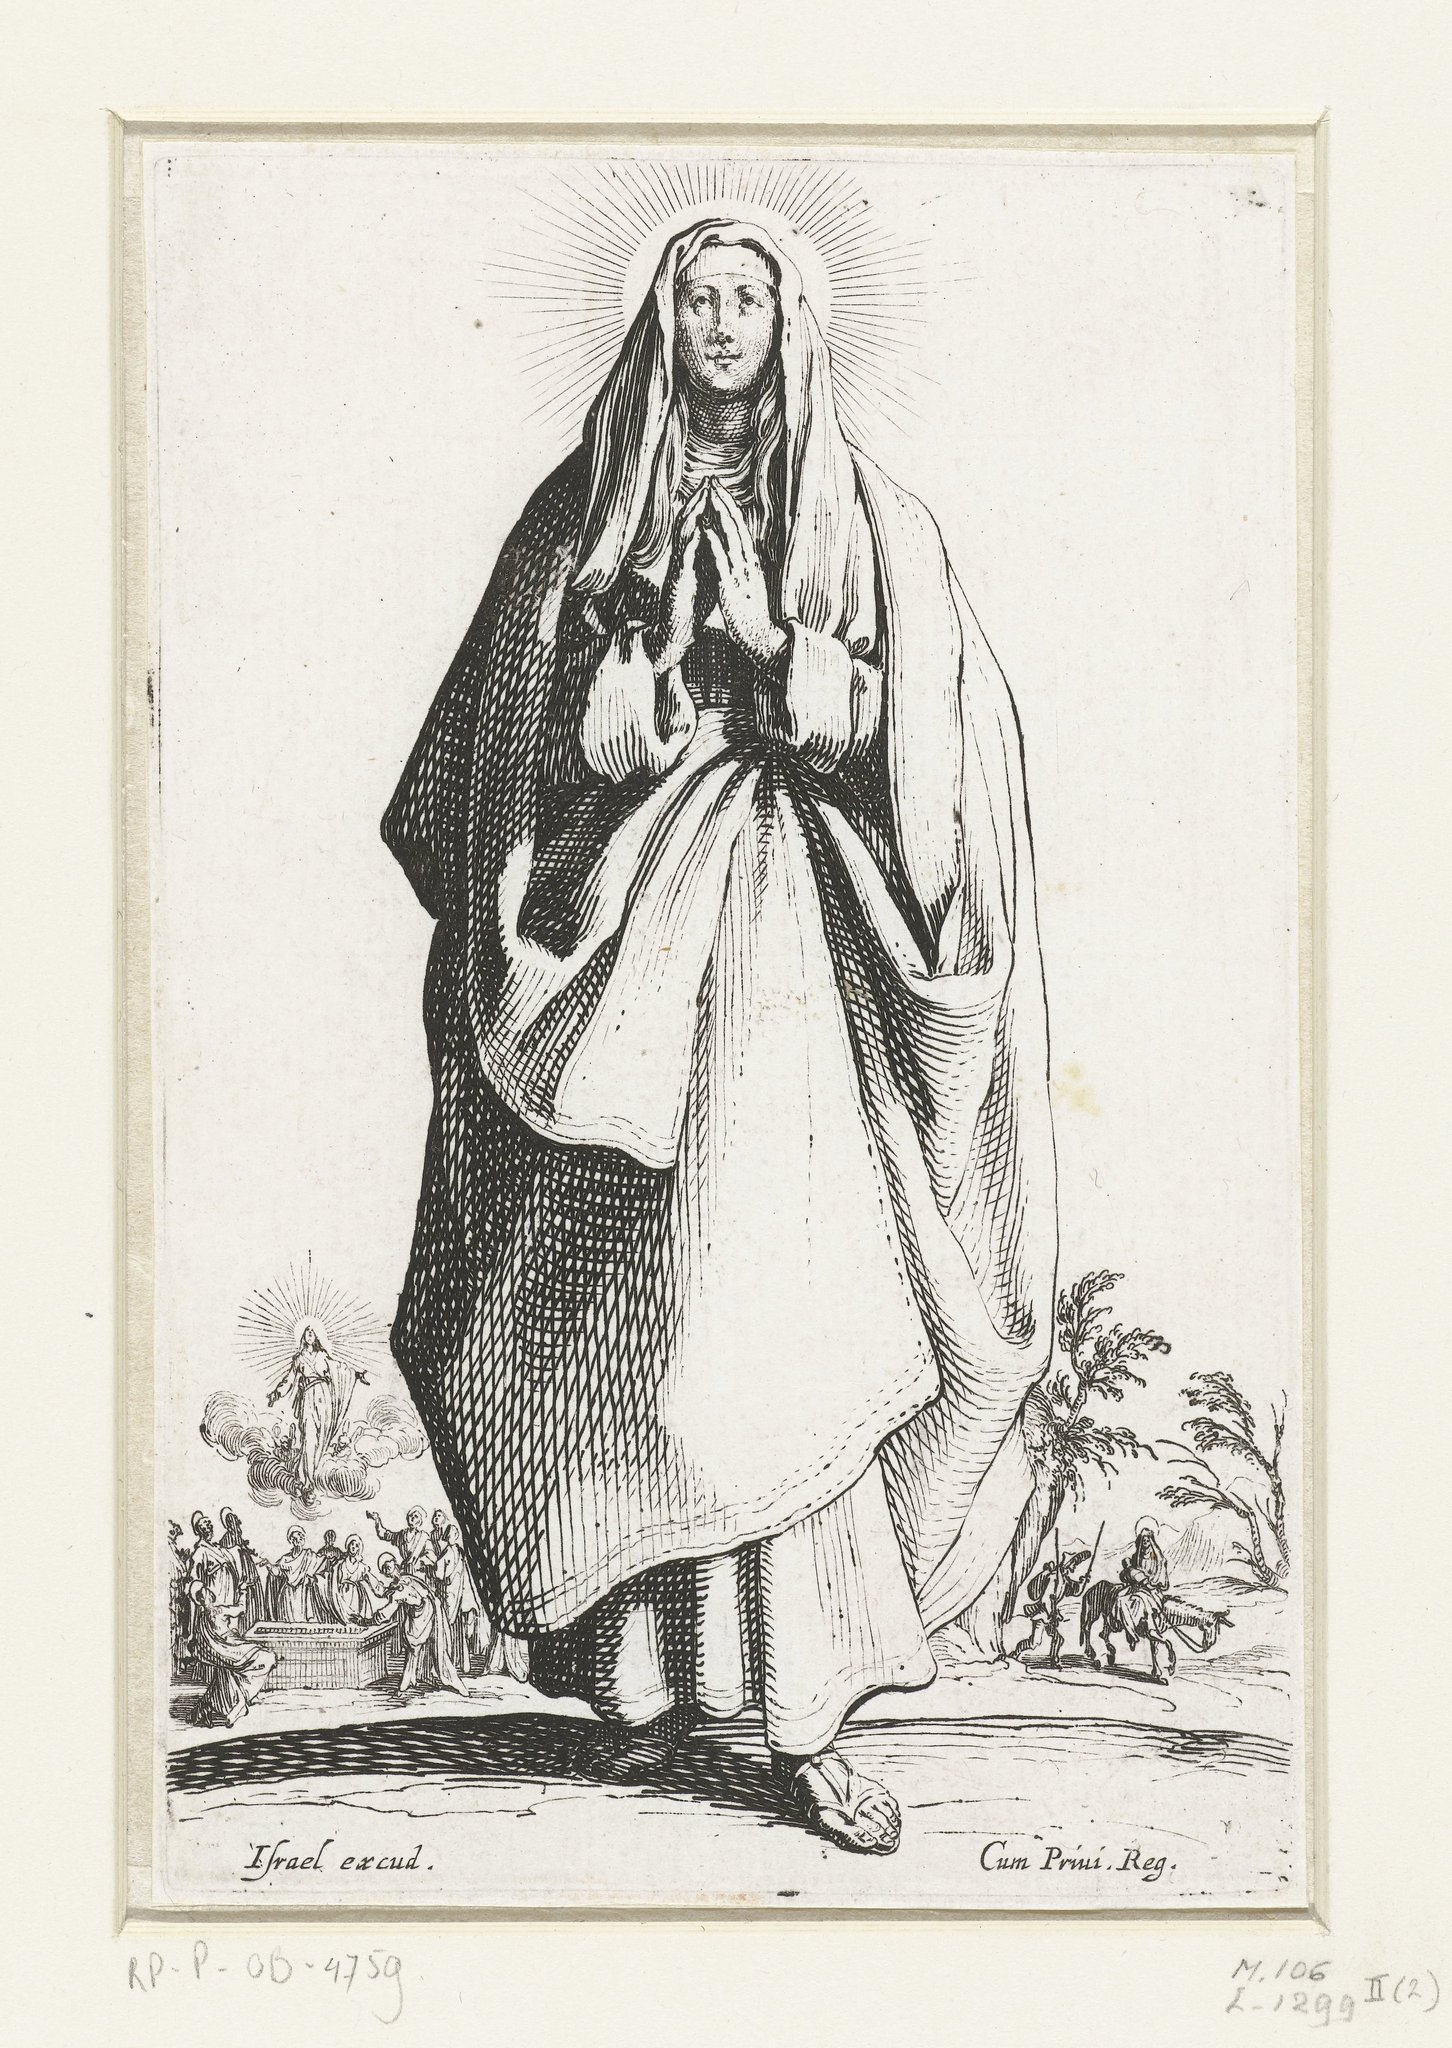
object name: print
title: De grote apostelen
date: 1631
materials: paper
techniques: etching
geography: nancy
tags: the flight into egypt: mary, joseph, the child (and sometimes others) on their way; mary usually riding on an ass, the assumption of mary ('assumptio corporis'): she is borne into heaven by angels, mary as orante (sometimes called 'blacherniotissa')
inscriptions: collector's mark: Lugt 240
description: Maria, ten voeten uit, de handen bijeen als in gebed. Op de achtergrond rechts de vlucht naar Egypte en links Maria's hemelvaart. Deze prent is onderdeel van een reeks van 16 prenten, bestaande uit een titelblad en 15 portretten, voorstellende Christus, Maria en de apostelen.